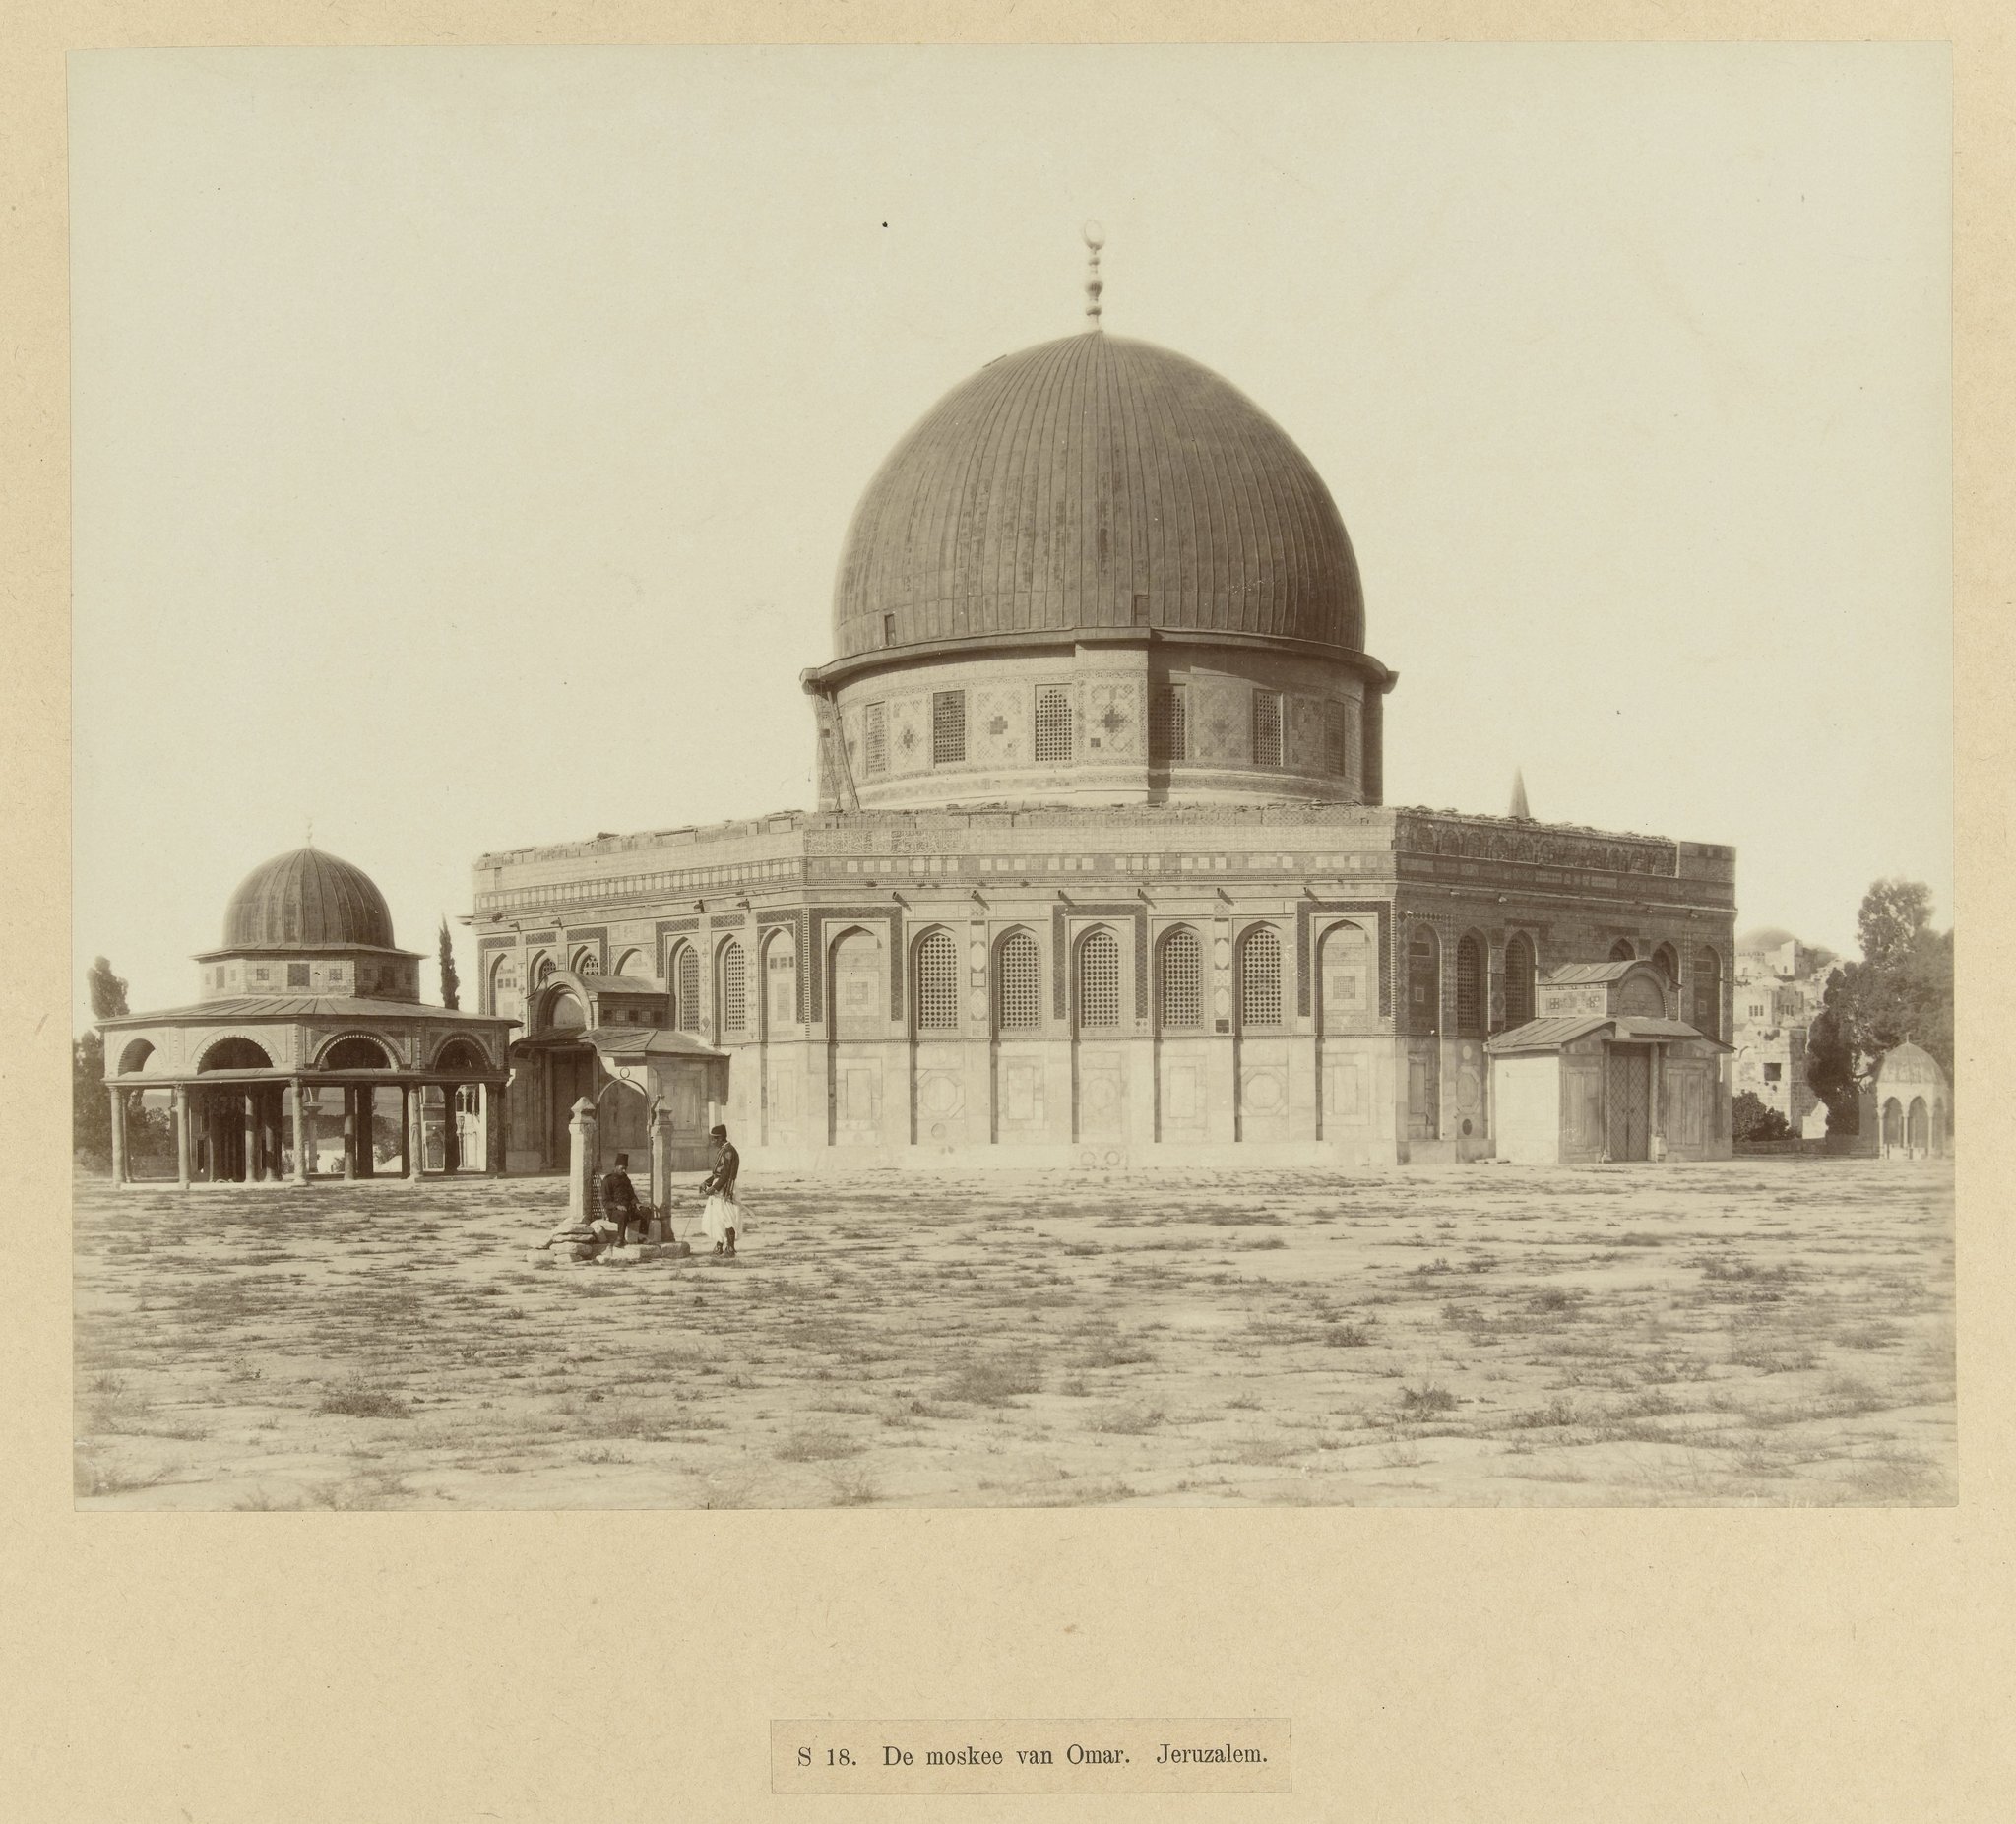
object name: photograph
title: Rotskoepel op de Tempelberg, Jeruzalem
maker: Anonymous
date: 1890-1895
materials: cardboard, paper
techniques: albumen print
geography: israel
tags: temple, shrine ~ islam, mohammedanism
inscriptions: title: ‘S 18. De moskee van Omar. Jeruzalem.’, stamp: ‘Gemeentelijke bibliotheek/ Rotterdam’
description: Onderdeel van een groep door fotograaf Richard Polak op reis verzamelde foto’s. Deze foto is samen met andere op zijn reizen verzamelde foto's tentoongesteld bij de Rotterdamsche Kunstkring (1895), Arti en Amicitiae te Amsterdam (1897-1898?) en Societeit 't Collegie te Kampen (datum vooralsnog onbekend).